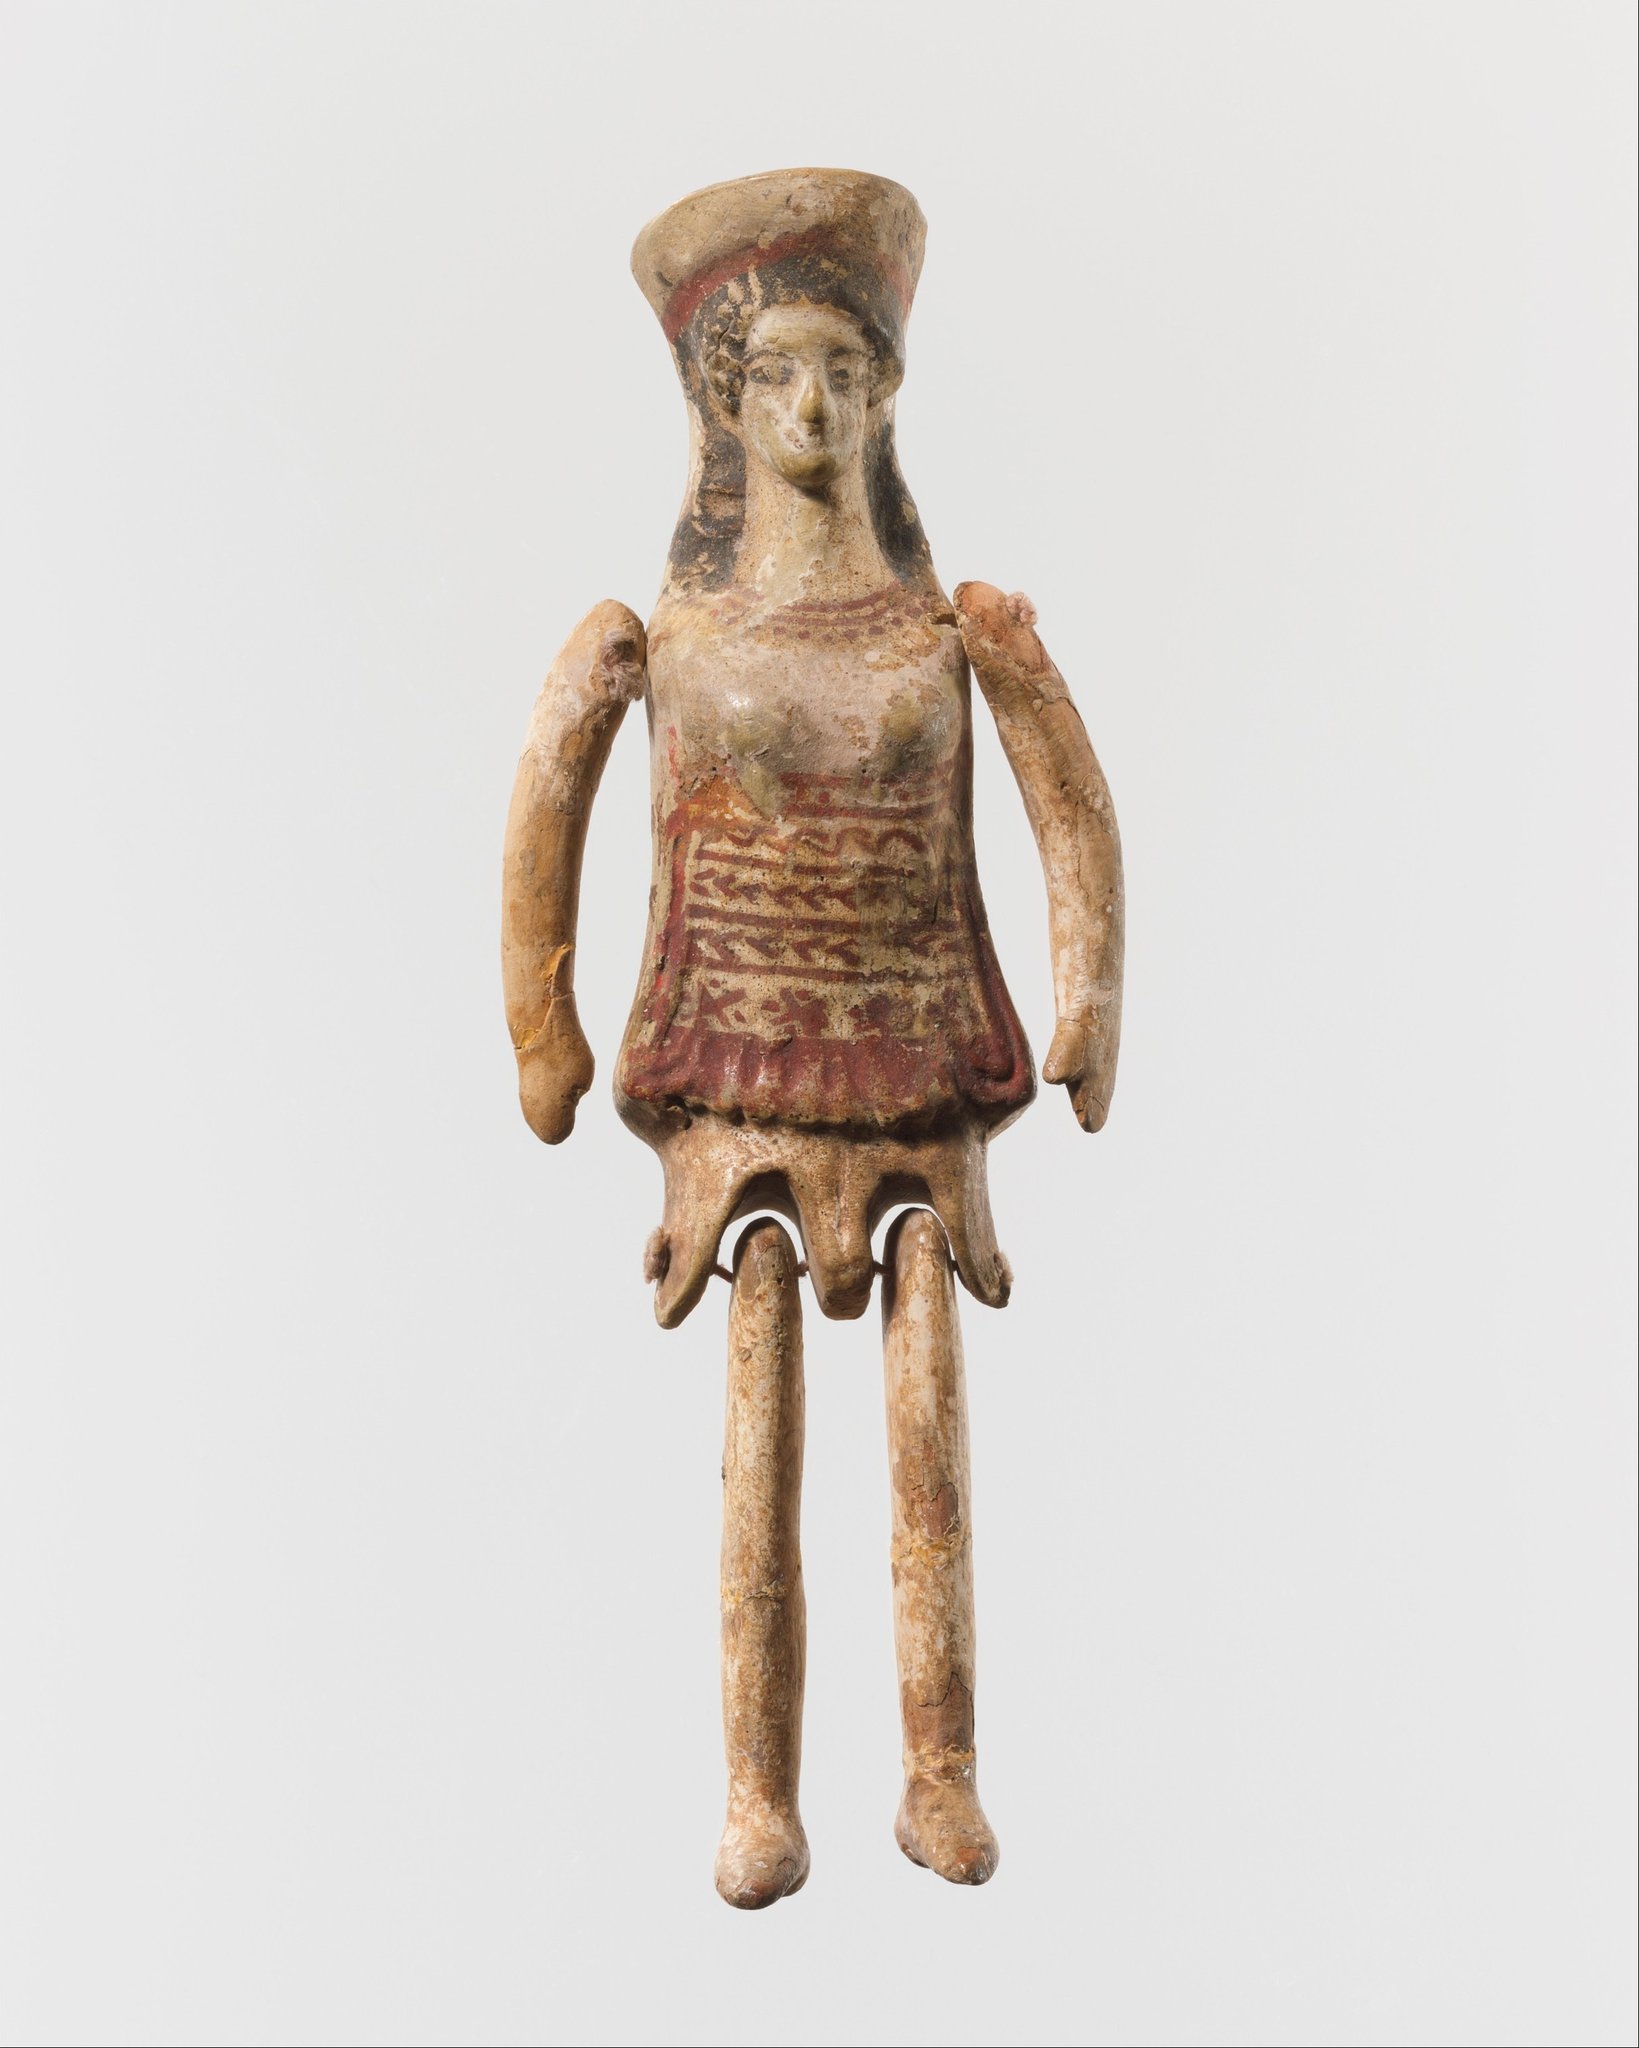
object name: doll, articulated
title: Figurine with articulated limbs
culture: greek, corinthian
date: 500-401 BCE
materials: terracotta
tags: dolls